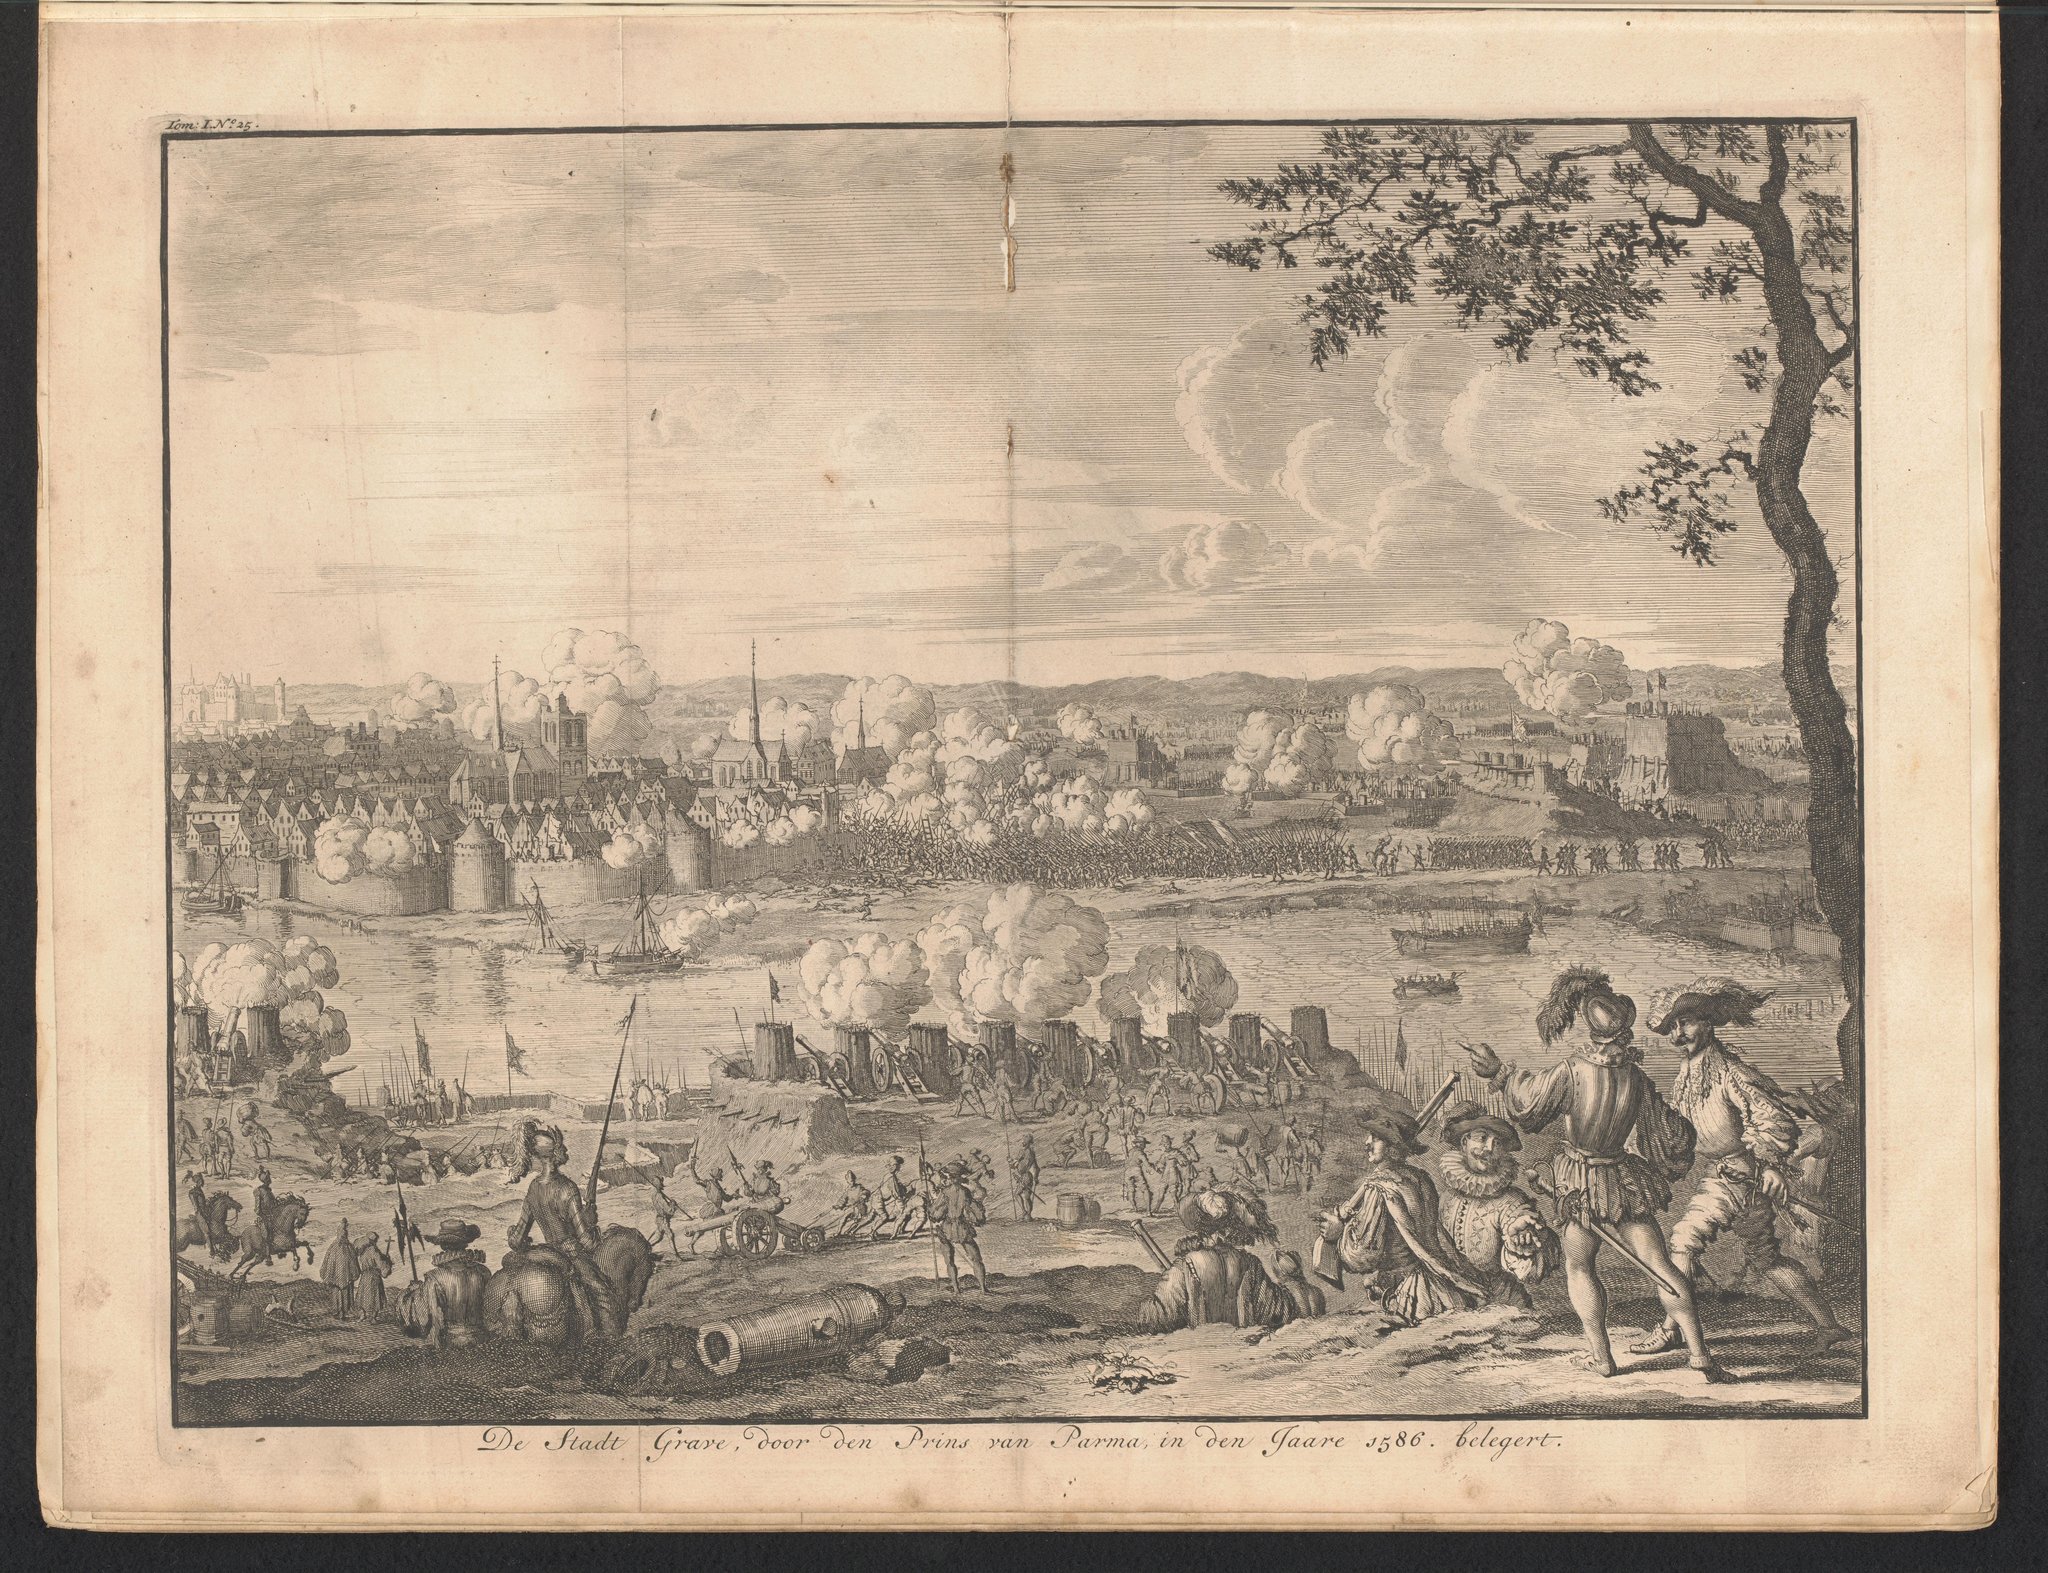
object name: print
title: De Stadt Grave, door den Prins van Parma, in den Jaare 1586. belegert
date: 1730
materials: paper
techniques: etching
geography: northern netherlands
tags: rome, alessandro farnese (landvoogd van de nederlanden en hertog van parma en piacenza), siege, position war, capture of city (after the siege), grave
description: Prent waarschijnlijk uit: Le Clerc, Jean. Geschiedenissen der Vereenigde Nederlanden, sedert den aanvang van die Republyk tot op den Vrede van Utrecht in 't jaar 1713 en het Tractaat van Barriere in 't jaar 1715 gesloten. Amsterdam: Zacharias Chatelain, 1730, dl. 1, p. 178-179. Eerdere staat gebruikt in: Bor, Pieter Christiaensz. Oorsprongk, begin, en vervolgh der Nederlandsche Oorlogen (...). Amsterdam: weduwe van Joannes van Someren, Abraham Wolfgangh, Hendrick en Dirk Boom, 1684, dl. 2, p. 699. Eerdere staat ook gebruikt in: Groot, Hugo de. Nederlandtsche Jaerboeken en Historien sedert het jaer MDLV tot het jaer MDCIX (...). Amsterdam: weduwe Joannes van Someren, Abraham Wolfgang en Hendrick en Dirk Boom, 1681, p. 152-153.